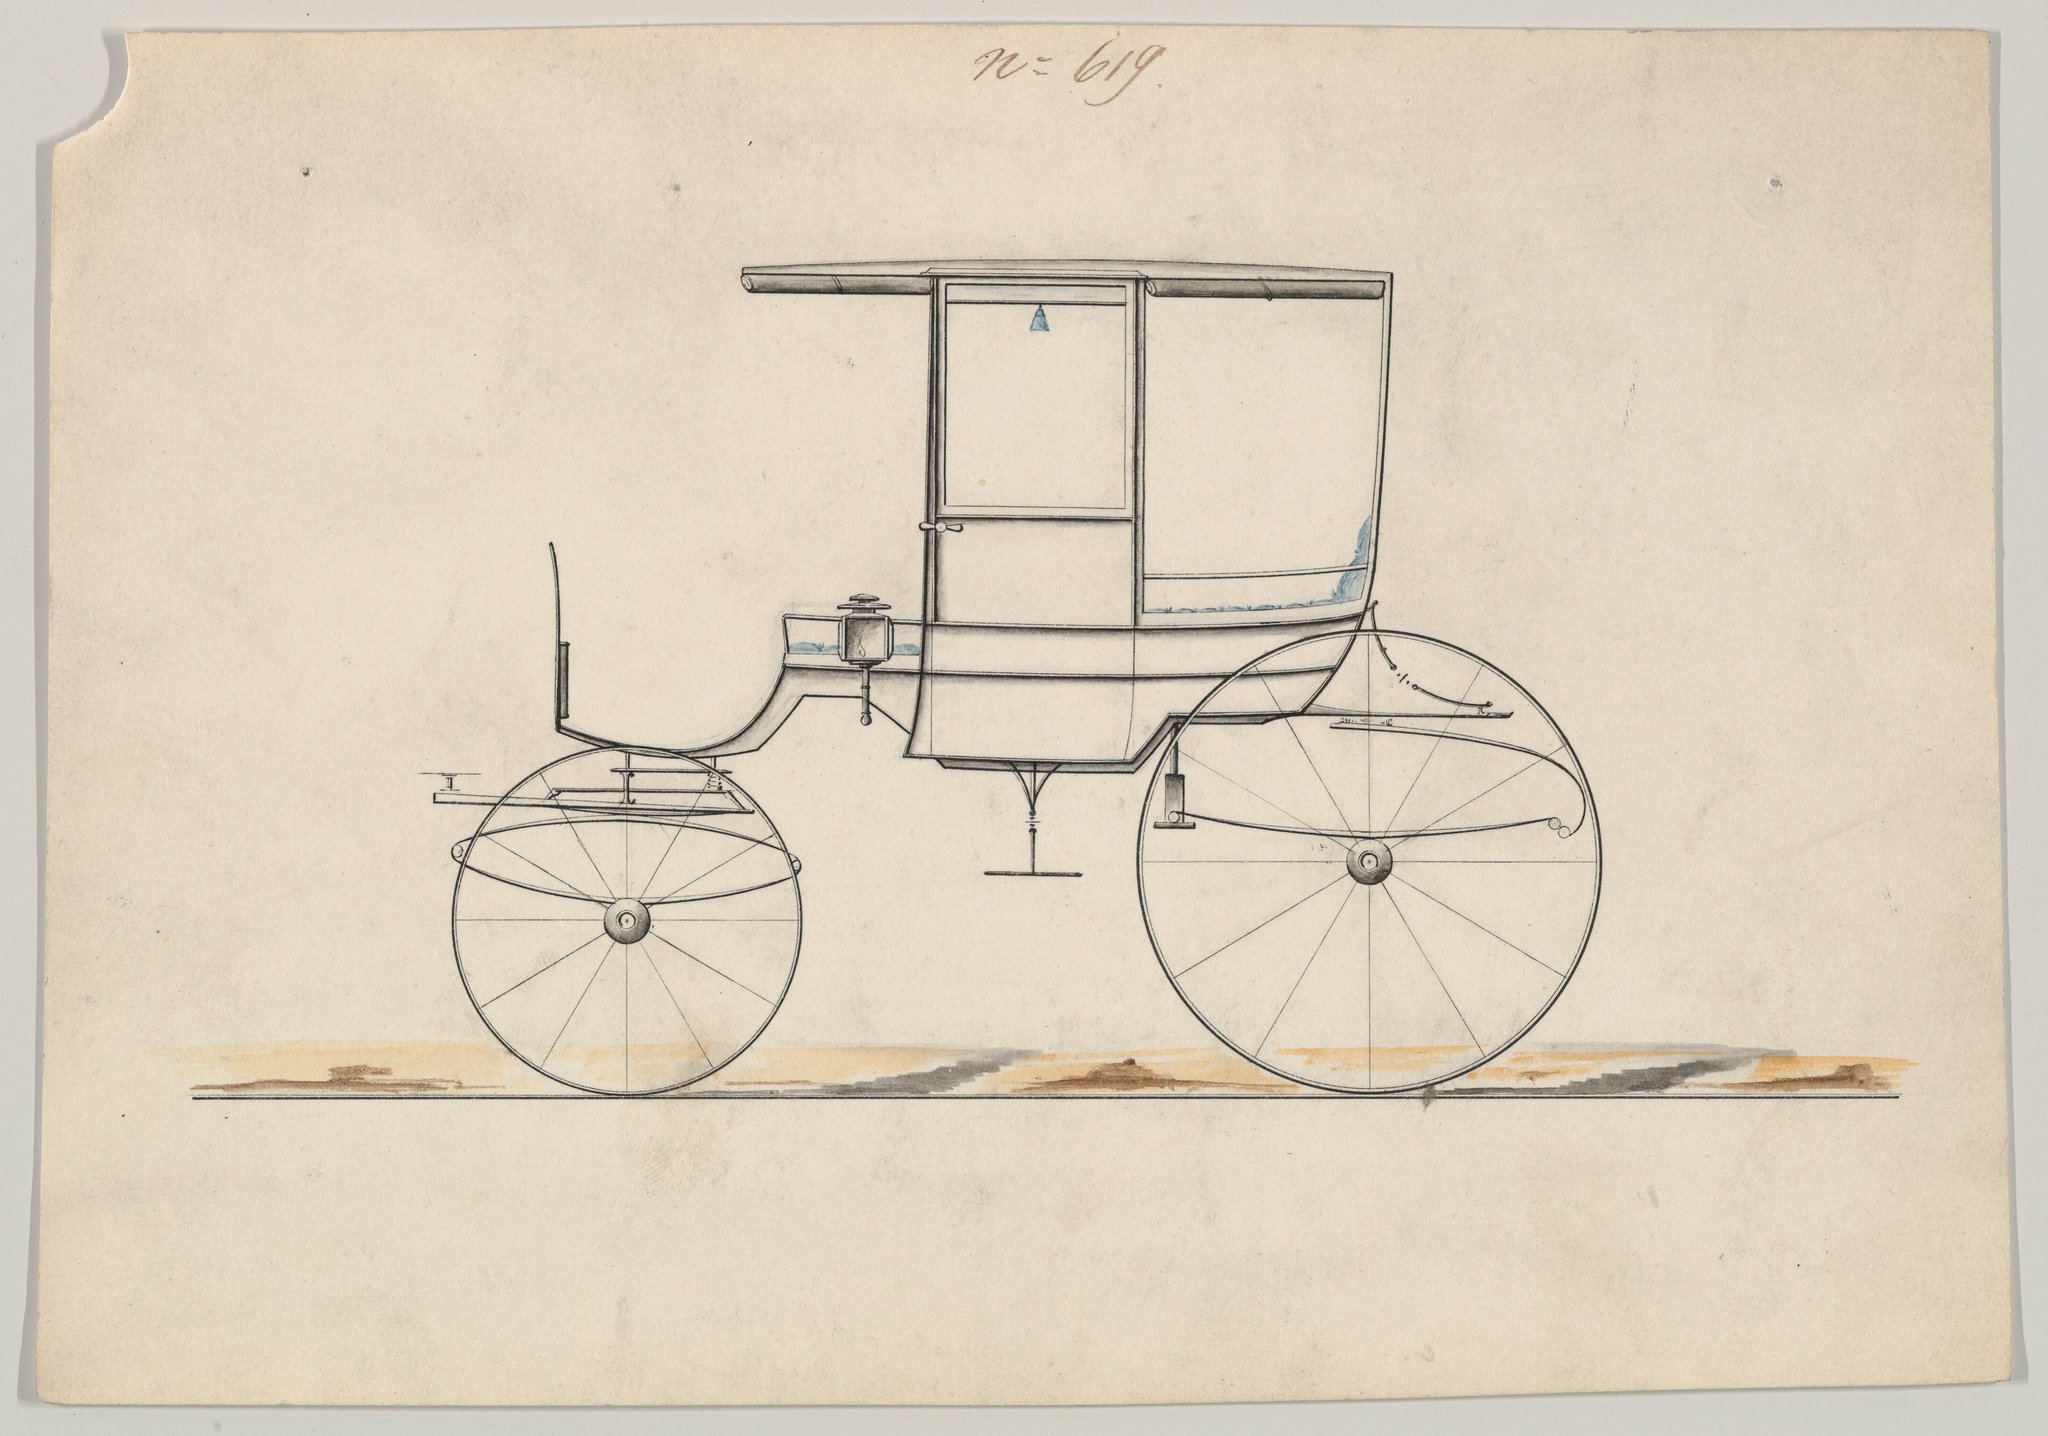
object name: drawing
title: Rockaway #619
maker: brewster & co.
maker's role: manufacturer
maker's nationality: american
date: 1865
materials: gouache, ink, watercolor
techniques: pen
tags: carriages